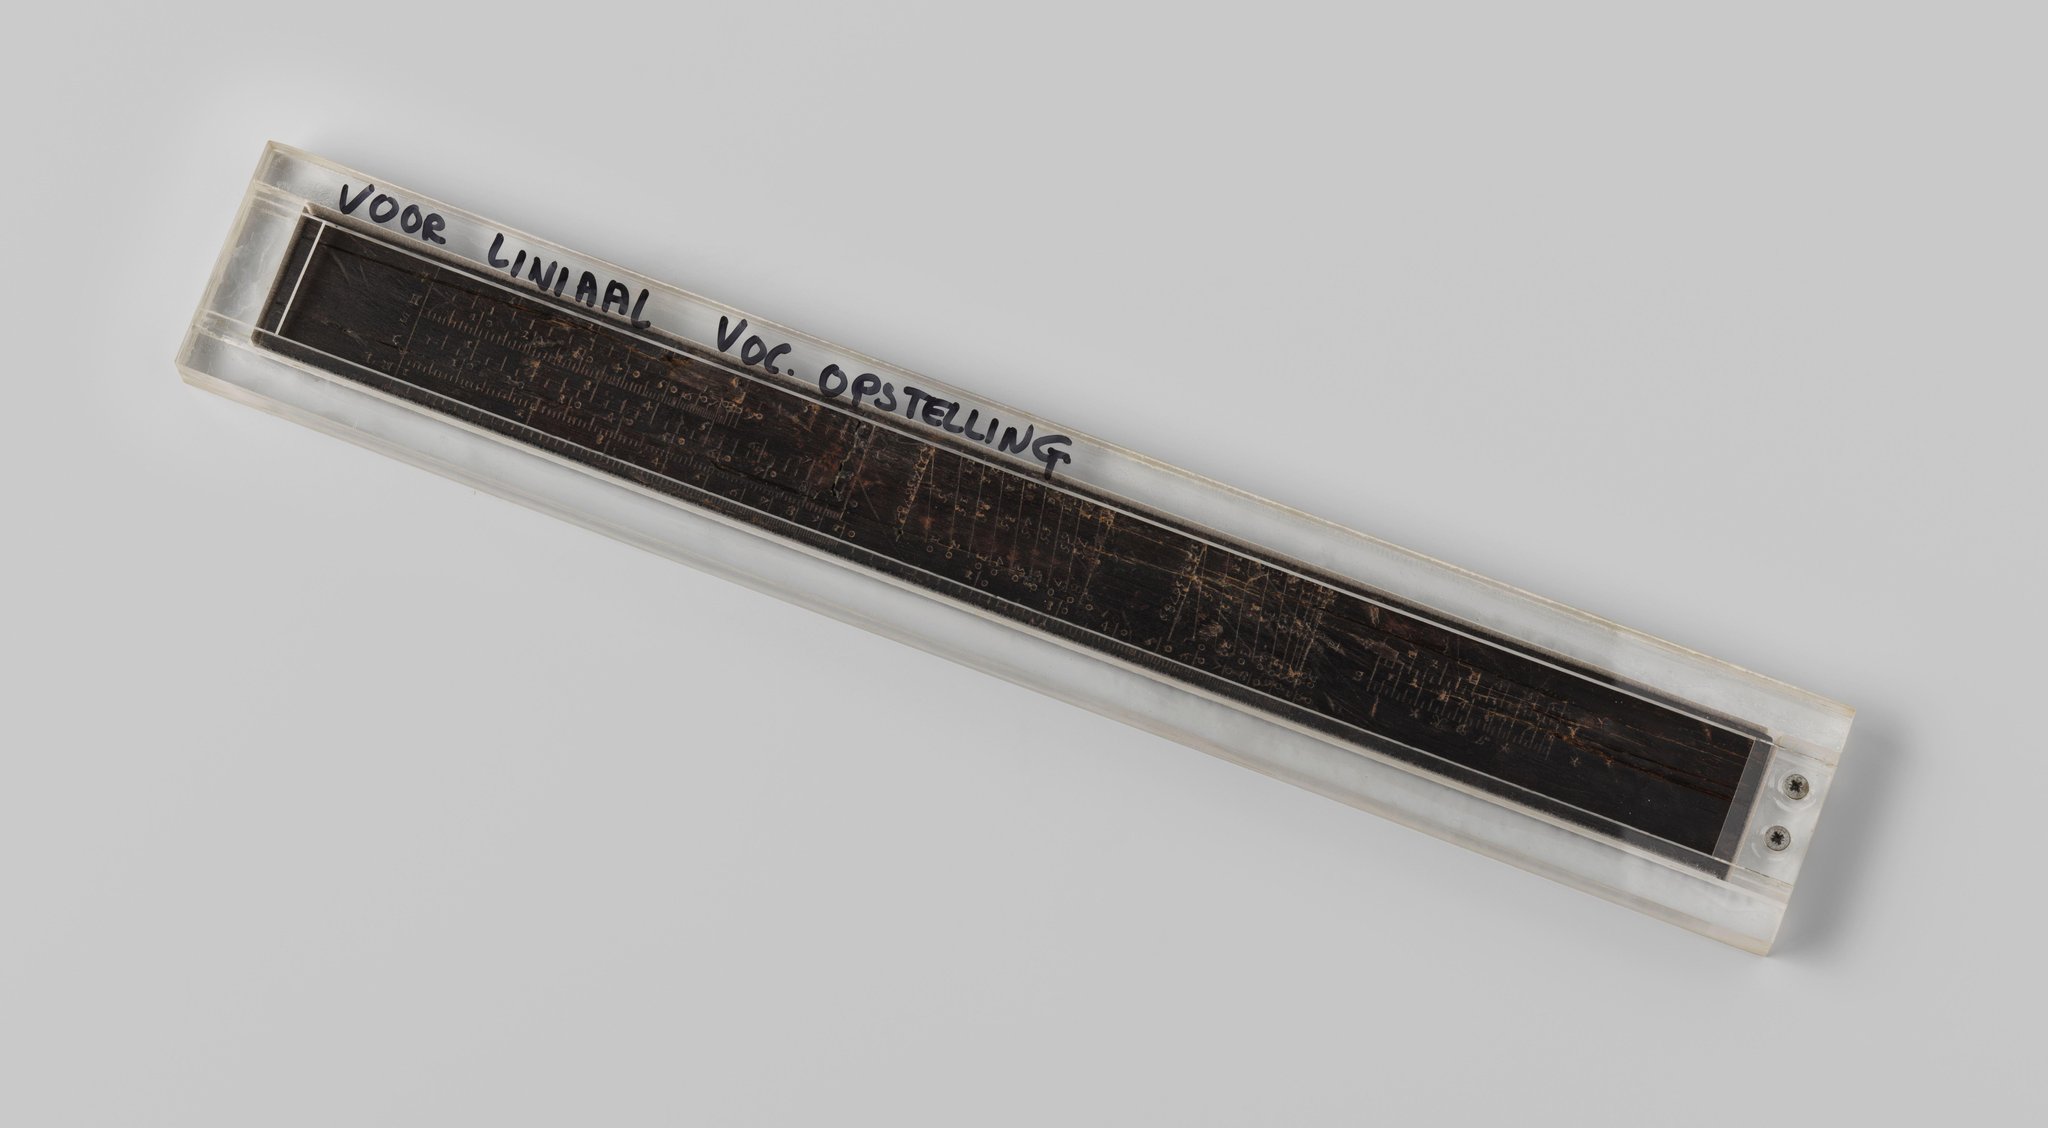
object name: schaalstok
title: Plane scale or logaritmic ruler from the wreck of the Dutch East Indiaman Hollandia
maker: johannes van keulen (i)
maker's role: bookseller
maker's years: 1653-1715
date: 1700-1743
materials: wood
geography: netherlands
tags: verenigde oostindische compagnie, hollandia (schip), annet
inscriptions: initials: ‘J V K’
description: Tools and instruments, navigation, plane scale; ruler: oblong, straight, rectangular, flat, one longitudinal edge bevelled, different (logaritmic) scales inscribed on both sides, as well as a maker's mark [initials JVK, Jan van Keulen], small tubes inserted into certain points on the scales.